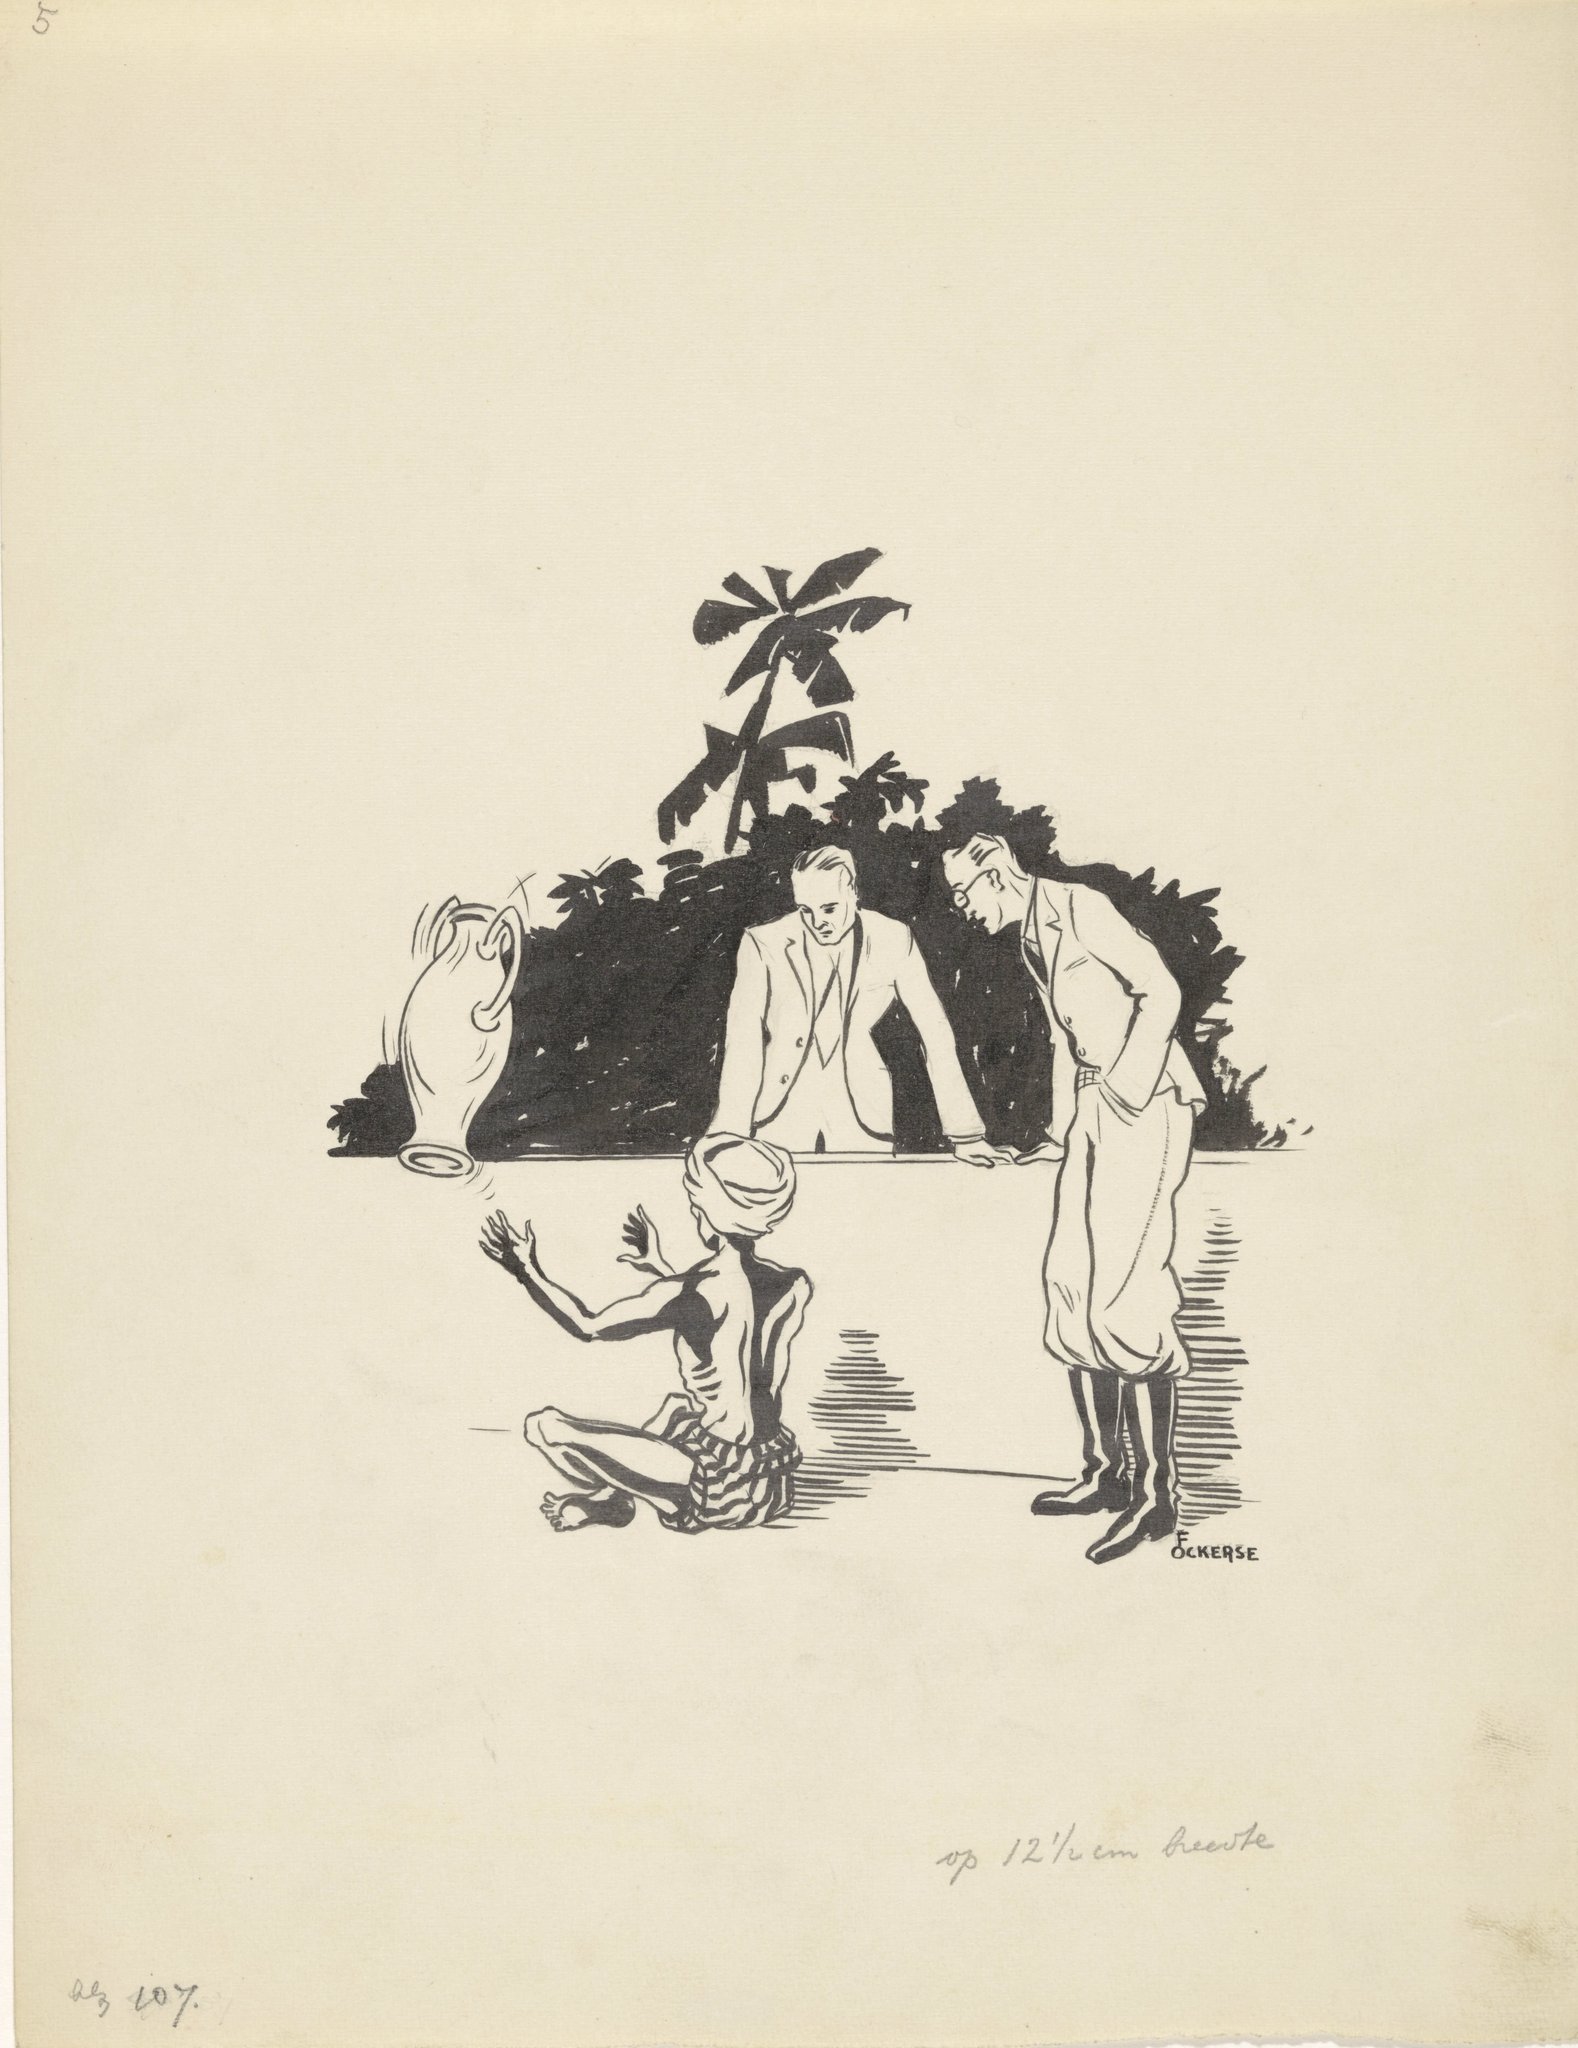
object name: boekillustratie ontwerp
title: Man laat een kruik zweven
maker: f. ockerse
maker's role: draughtsman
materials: paint, paper, pencil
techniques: brush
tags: levitation ~ mysticism, head-gear: turban, container of ceramics: jar, jug, pot, vase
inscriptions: annotation: ‘5/ blz 107.’, :, signature: ‘F/ OCKERSE’, collector's mark: Lugt 2228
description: Een man zit in kleermakerszit bij een muur. Hij draagt een tulband en houdt beide handen in de lucht. Voor hem zweeft een kruik in de lucht. Twee mannen in pakken kijken toe.